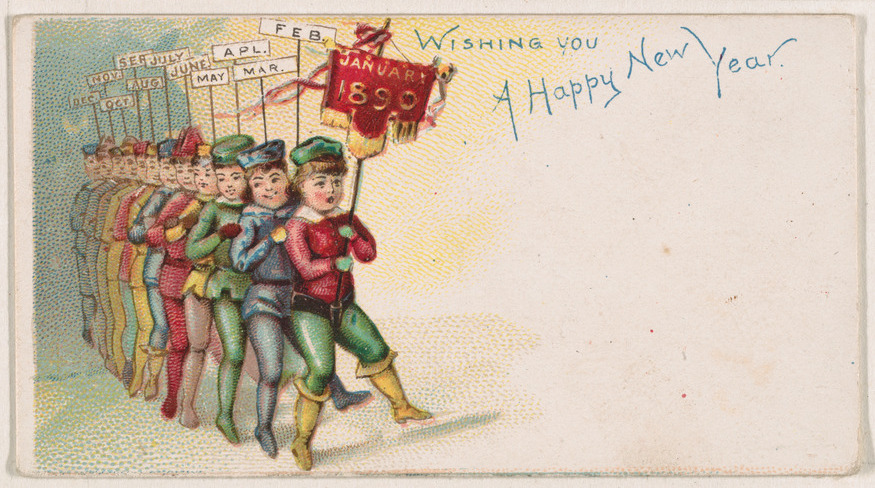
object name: print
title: Wishing You a Happy New Year, from the New Years 1890 series (N227) issued by Kinney Bros.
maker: kinney brothers tobacco company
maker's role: publisher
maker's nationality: american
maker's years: 1869-2011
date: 1889-1890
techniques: color lithograph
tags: girls,walking